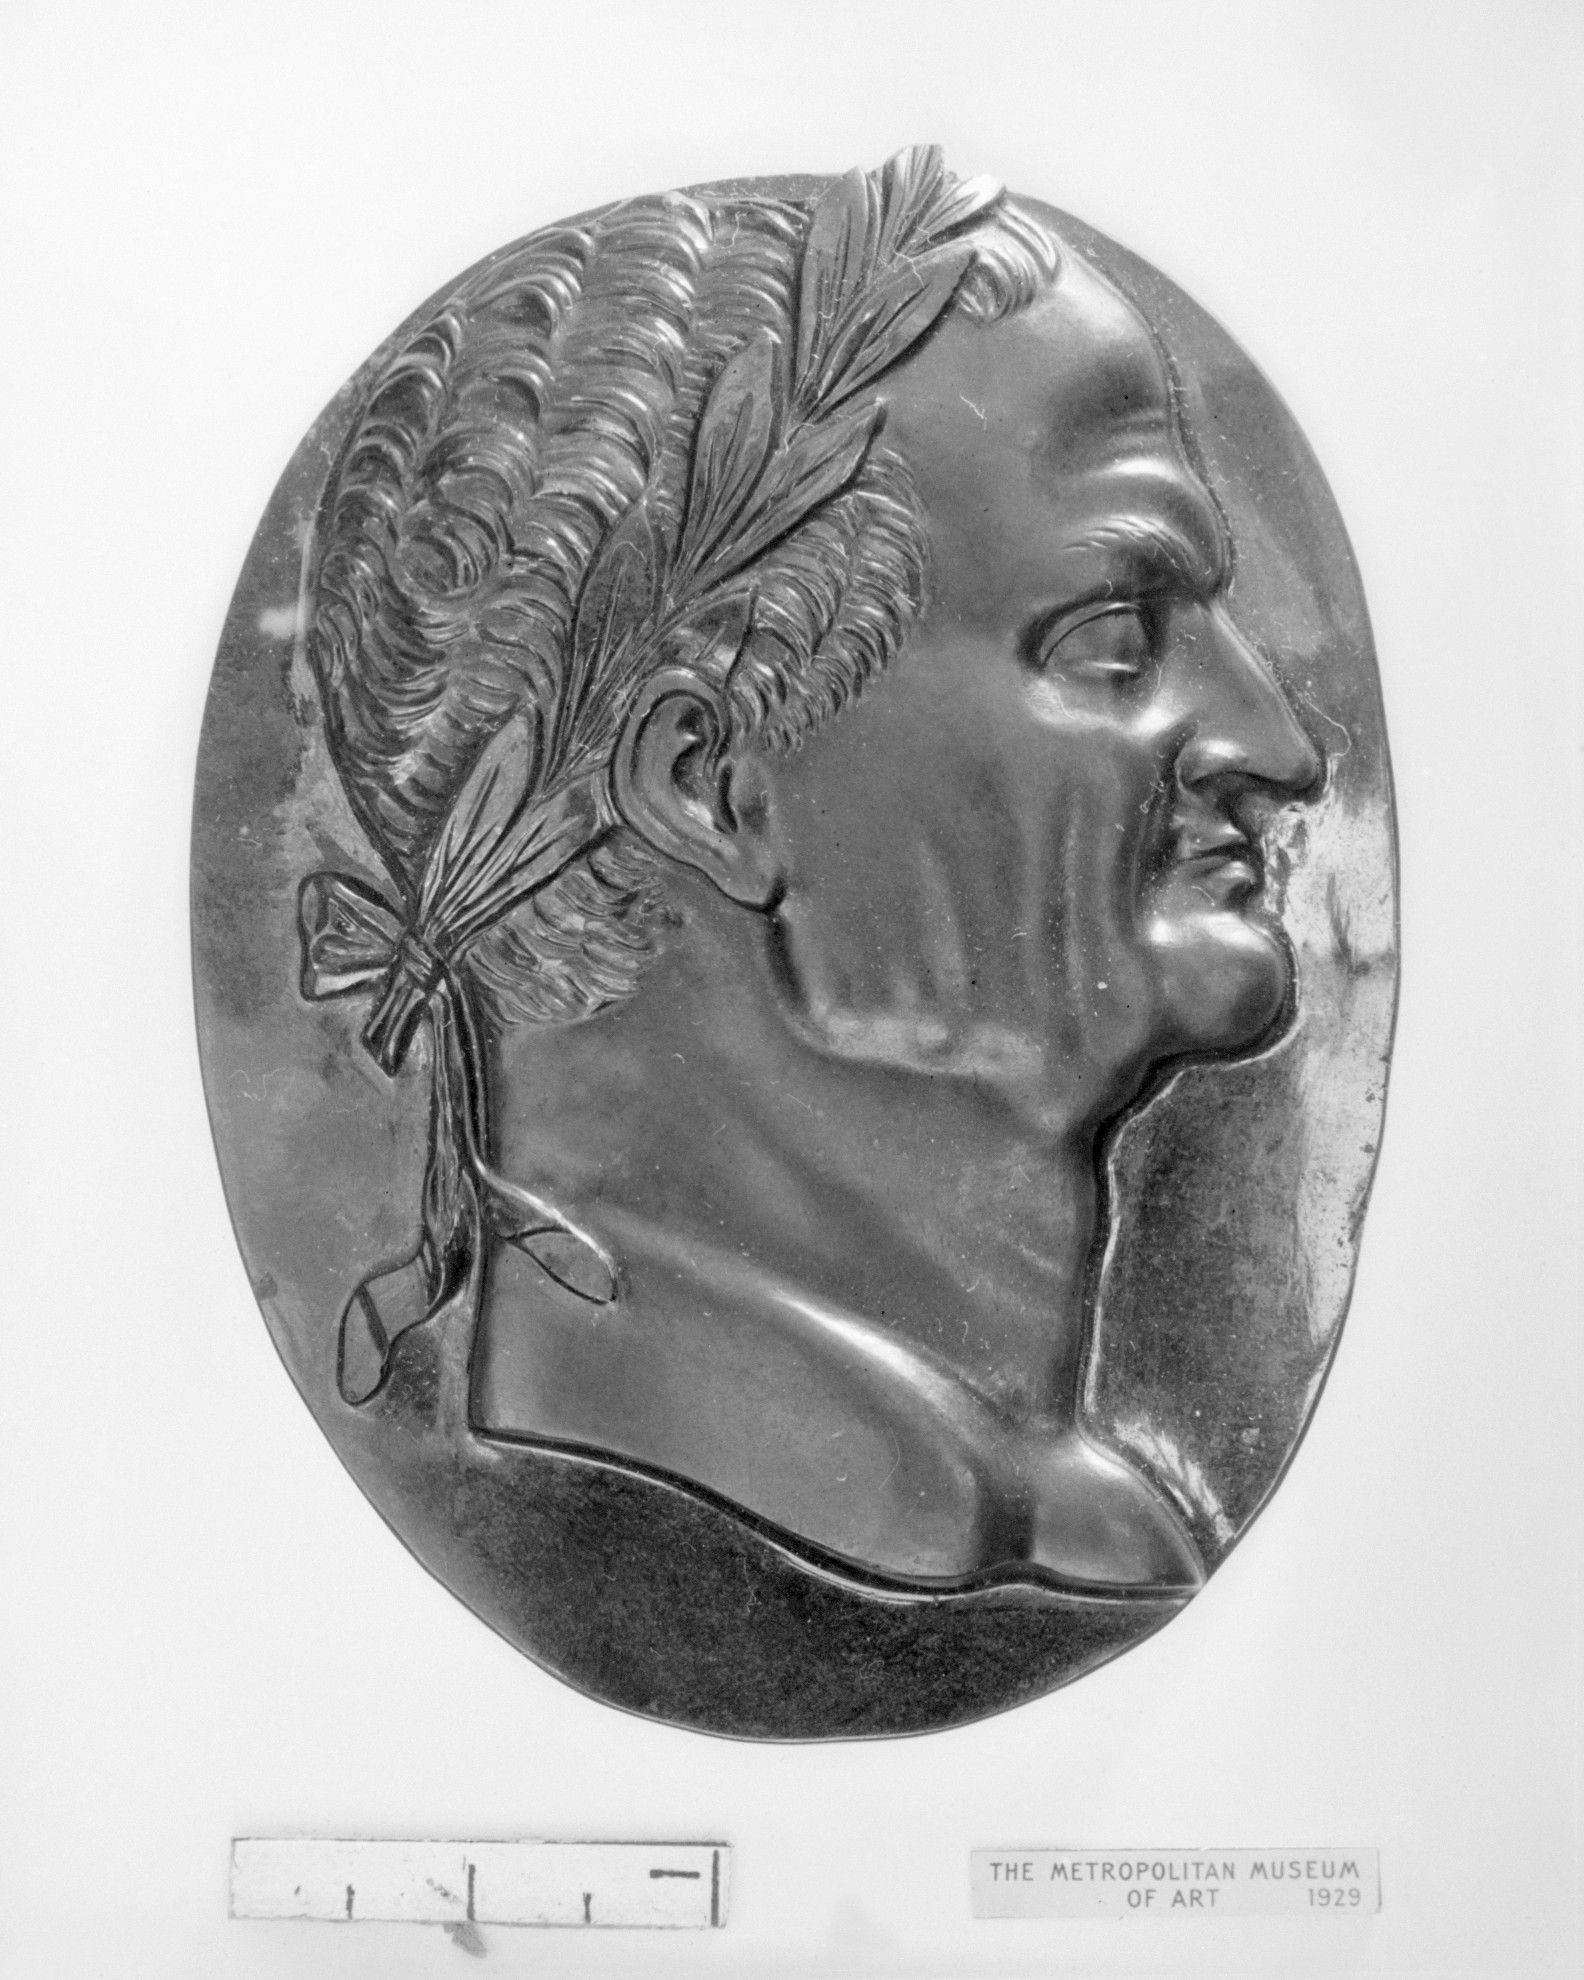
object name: cameo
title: Vespasian (Titus Flavius Vespasianus, A.D. 9–79)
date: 1501-1700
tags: men,profiles